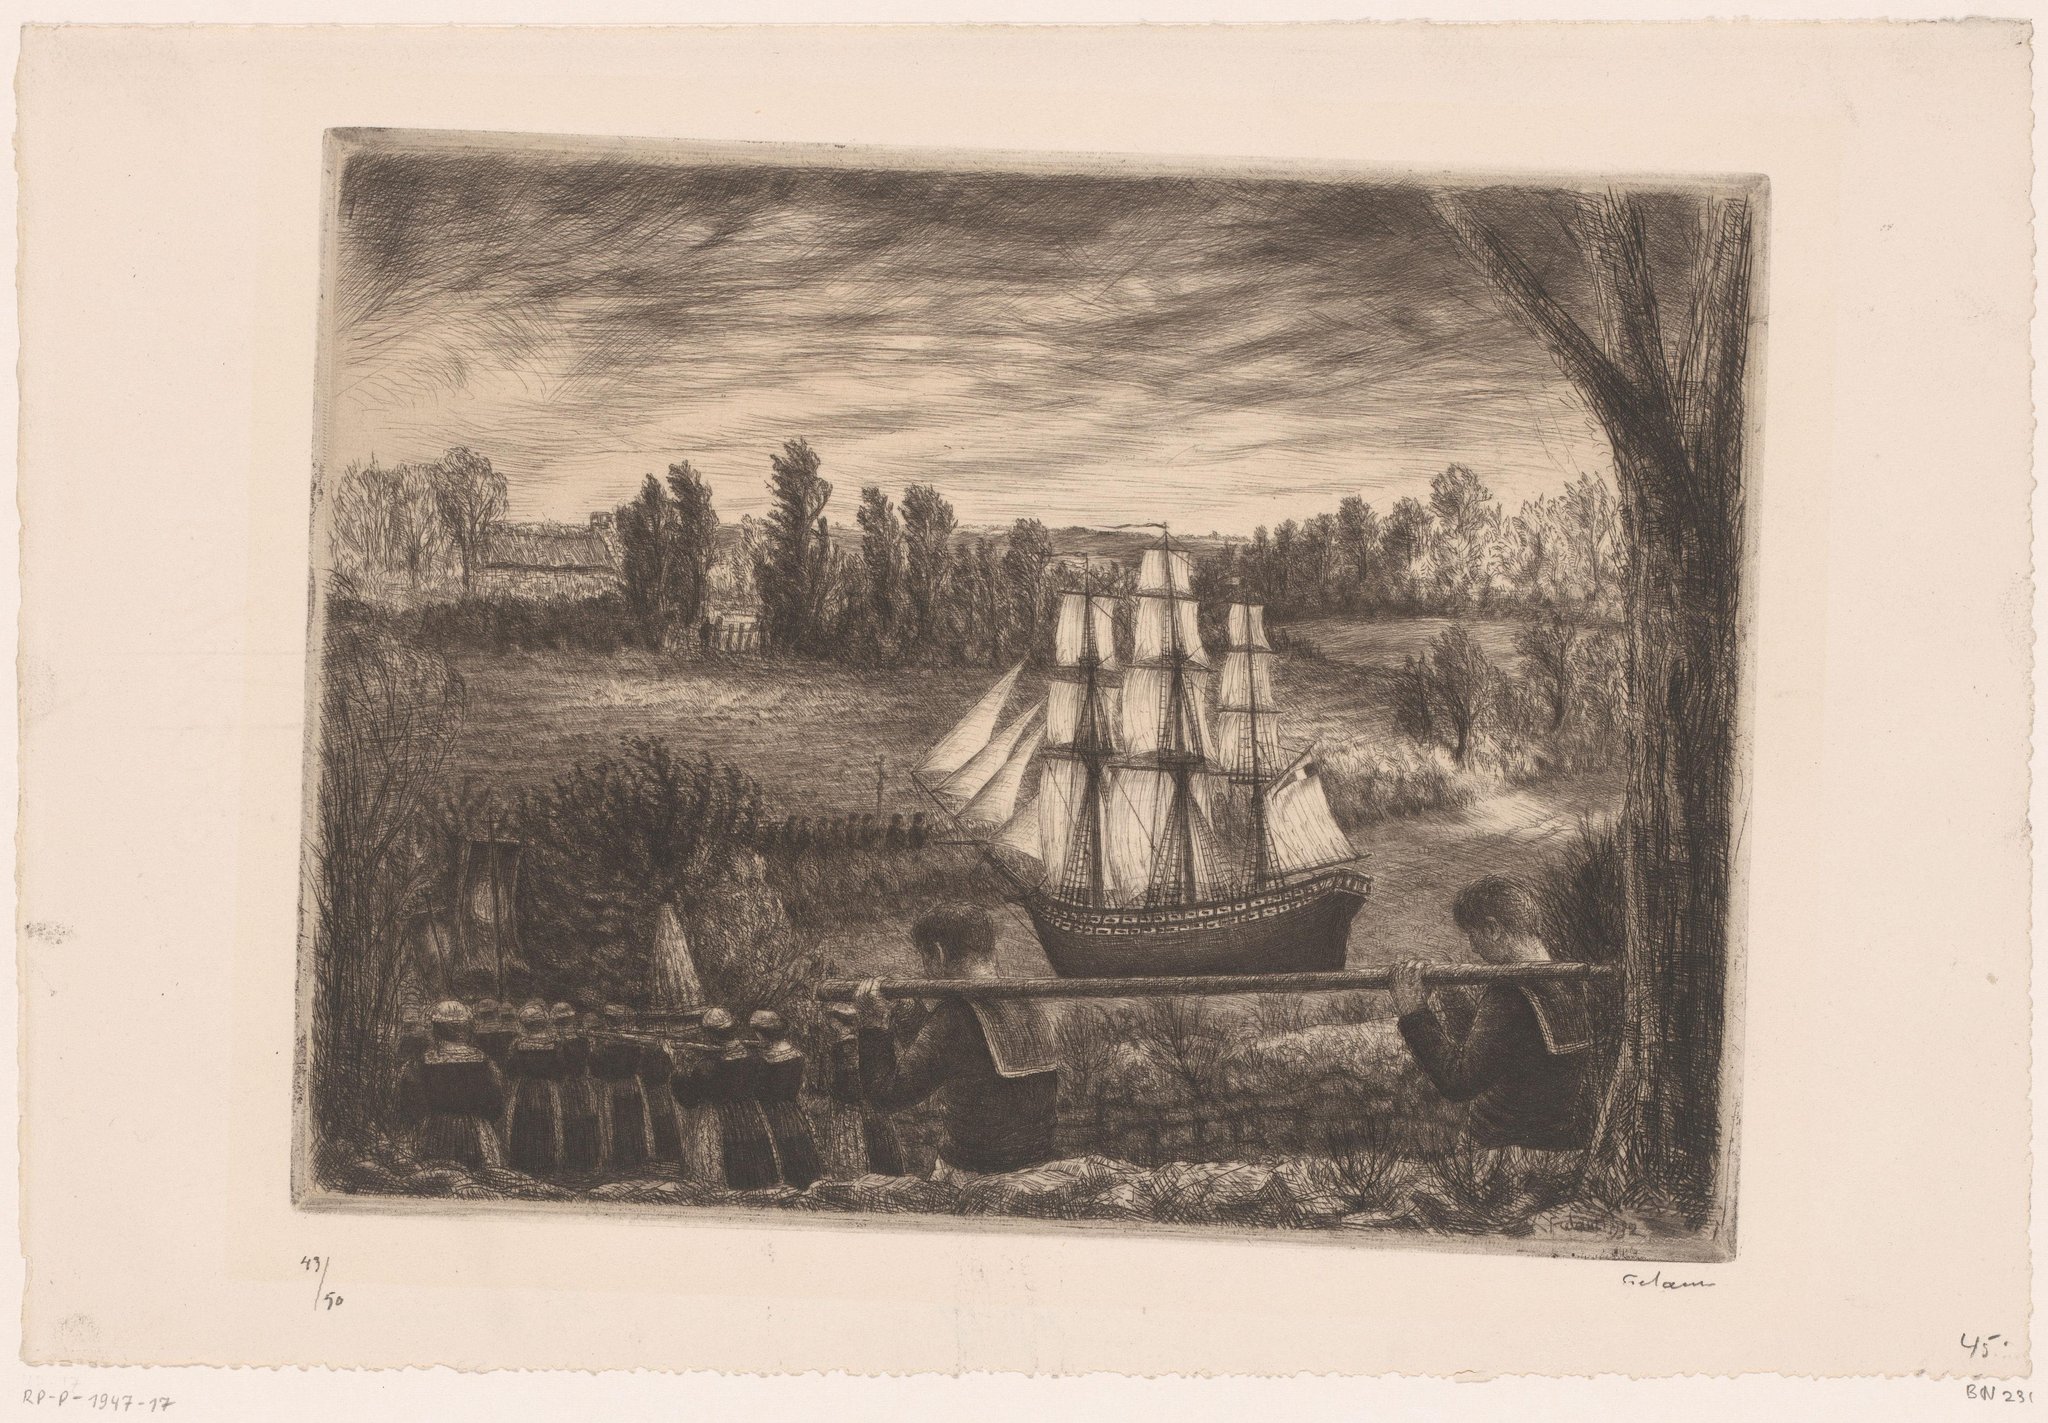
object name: print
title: Maaiers onder een boom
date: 1927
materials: paper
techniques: drypoint, etching, intaglio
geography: paris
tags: trees, reaping, picking, mowing ~ harvest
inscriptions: collector's mark: Lugt 2254, collector's mark: Lugt 2228